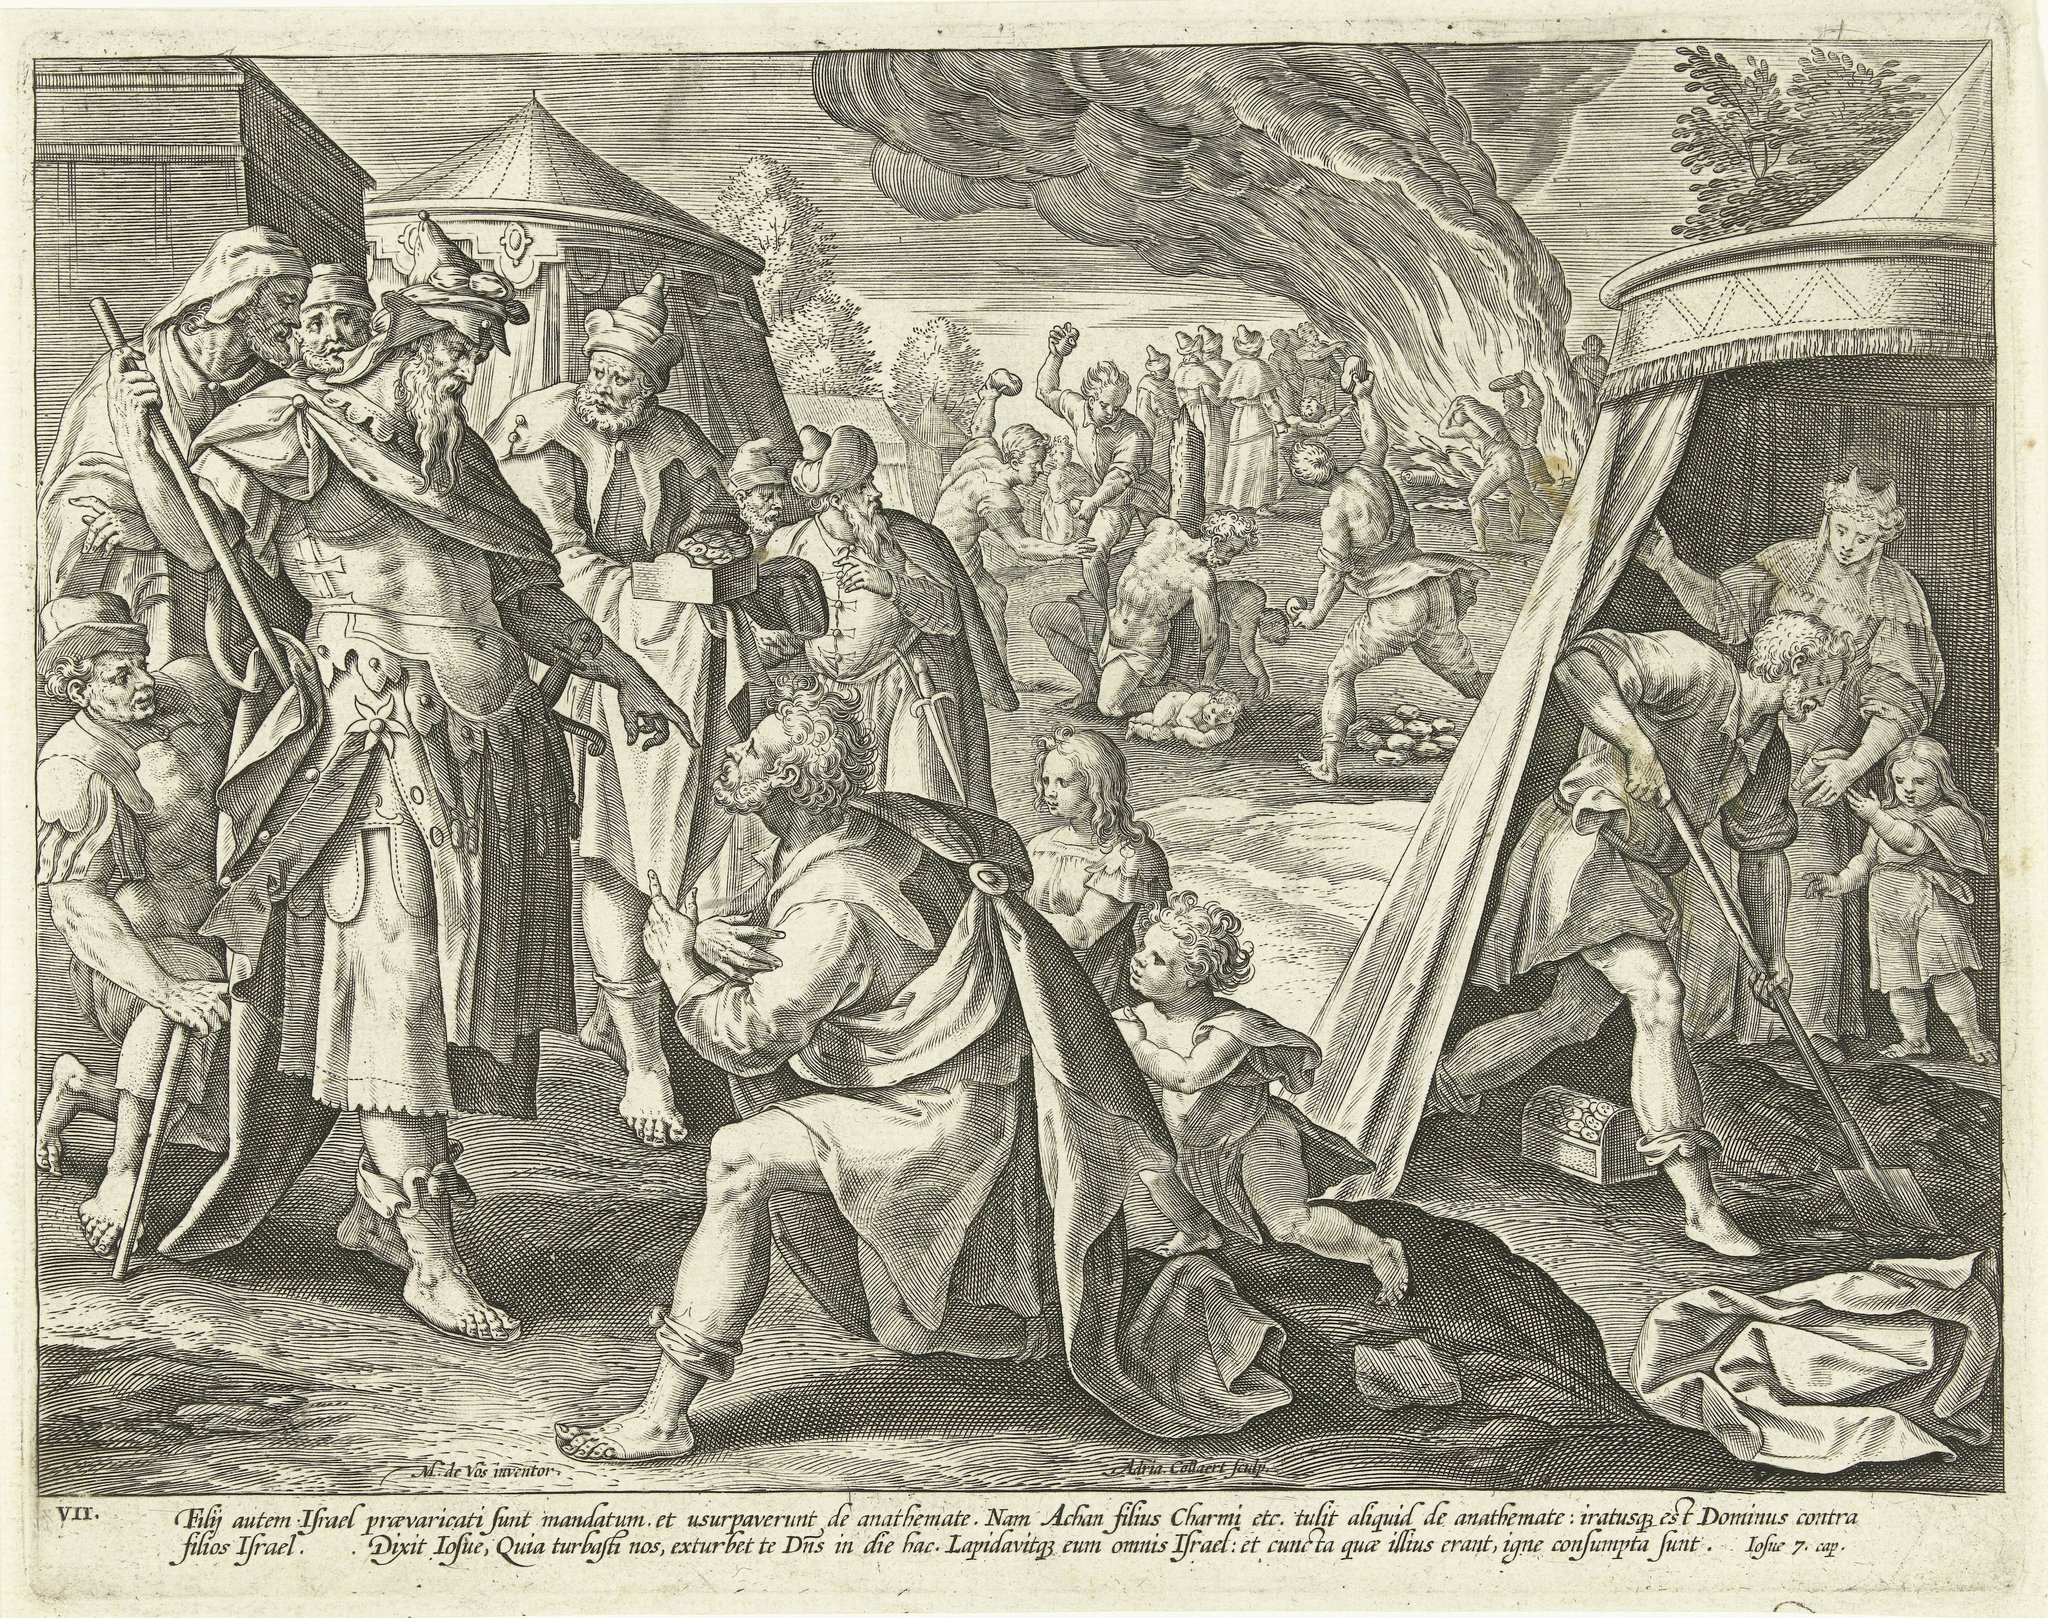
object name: print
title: Decalogvs cvm acerbissimis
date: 1585-1589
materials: paper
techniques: engraving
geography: antwerp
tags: achan, his family and possessions (including the stolen spoils) are taken to the valley of achor to be stoned, the goods, stolen from the spoils of jericho, are found buried in achan's tent and brought to joshua, achan confesses to have taken from the spoils a garment and some silver and gold, 'you shall not steal' ~ separate representation of the eigth of the ten commandments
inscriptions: collector's mark: Lugt 2228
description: Achan, een Israëliet, wordt door Jozua beschuldigd van diefstal. Hij heeft uit de oorlogsbuit gestolen die uitsluitend bestemd was voor God. De buit heeft hij begraven in zijn tent. Dit is een schending van het zevende Gebod: "Gij zult niet stelen". Op de achtergrond Achans straf: hij wordt samen met zijn familie gestenigd en hun lijken worden door de Israëlieten verbrand. De prent heeft een Latijns onderschrift. De prentserie beeldt de Tien Geboden uit door middel van scènes van het Oude Testament.